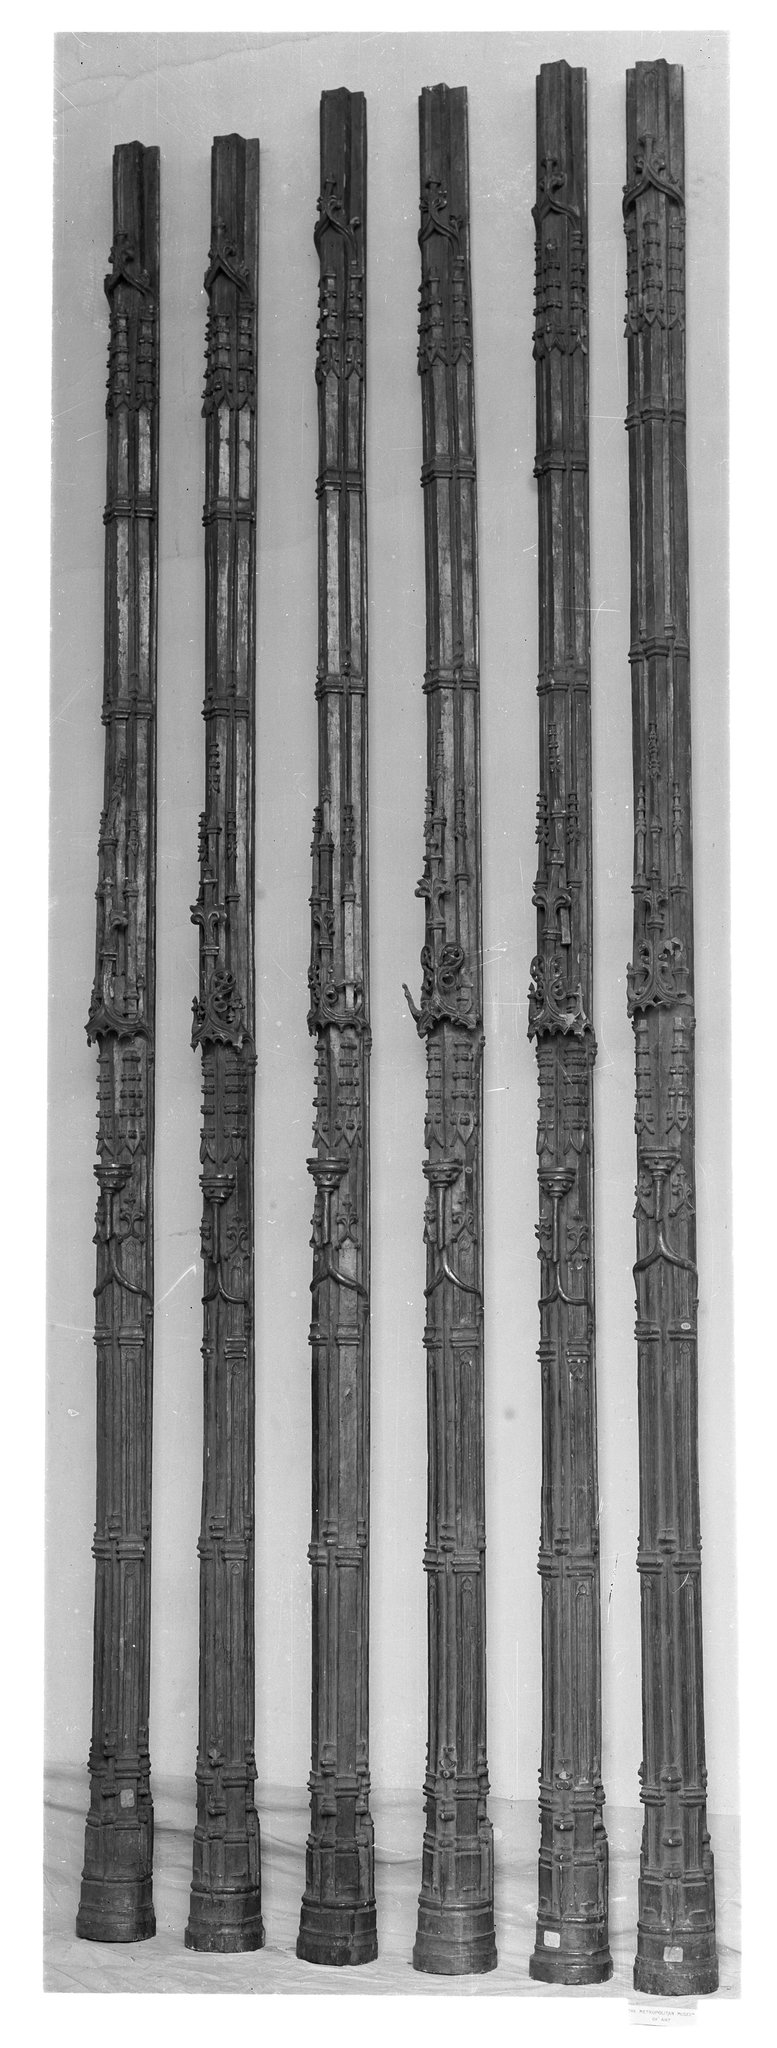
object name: pilaster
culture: french or italian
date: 1501-1600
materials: gold leaf, wood